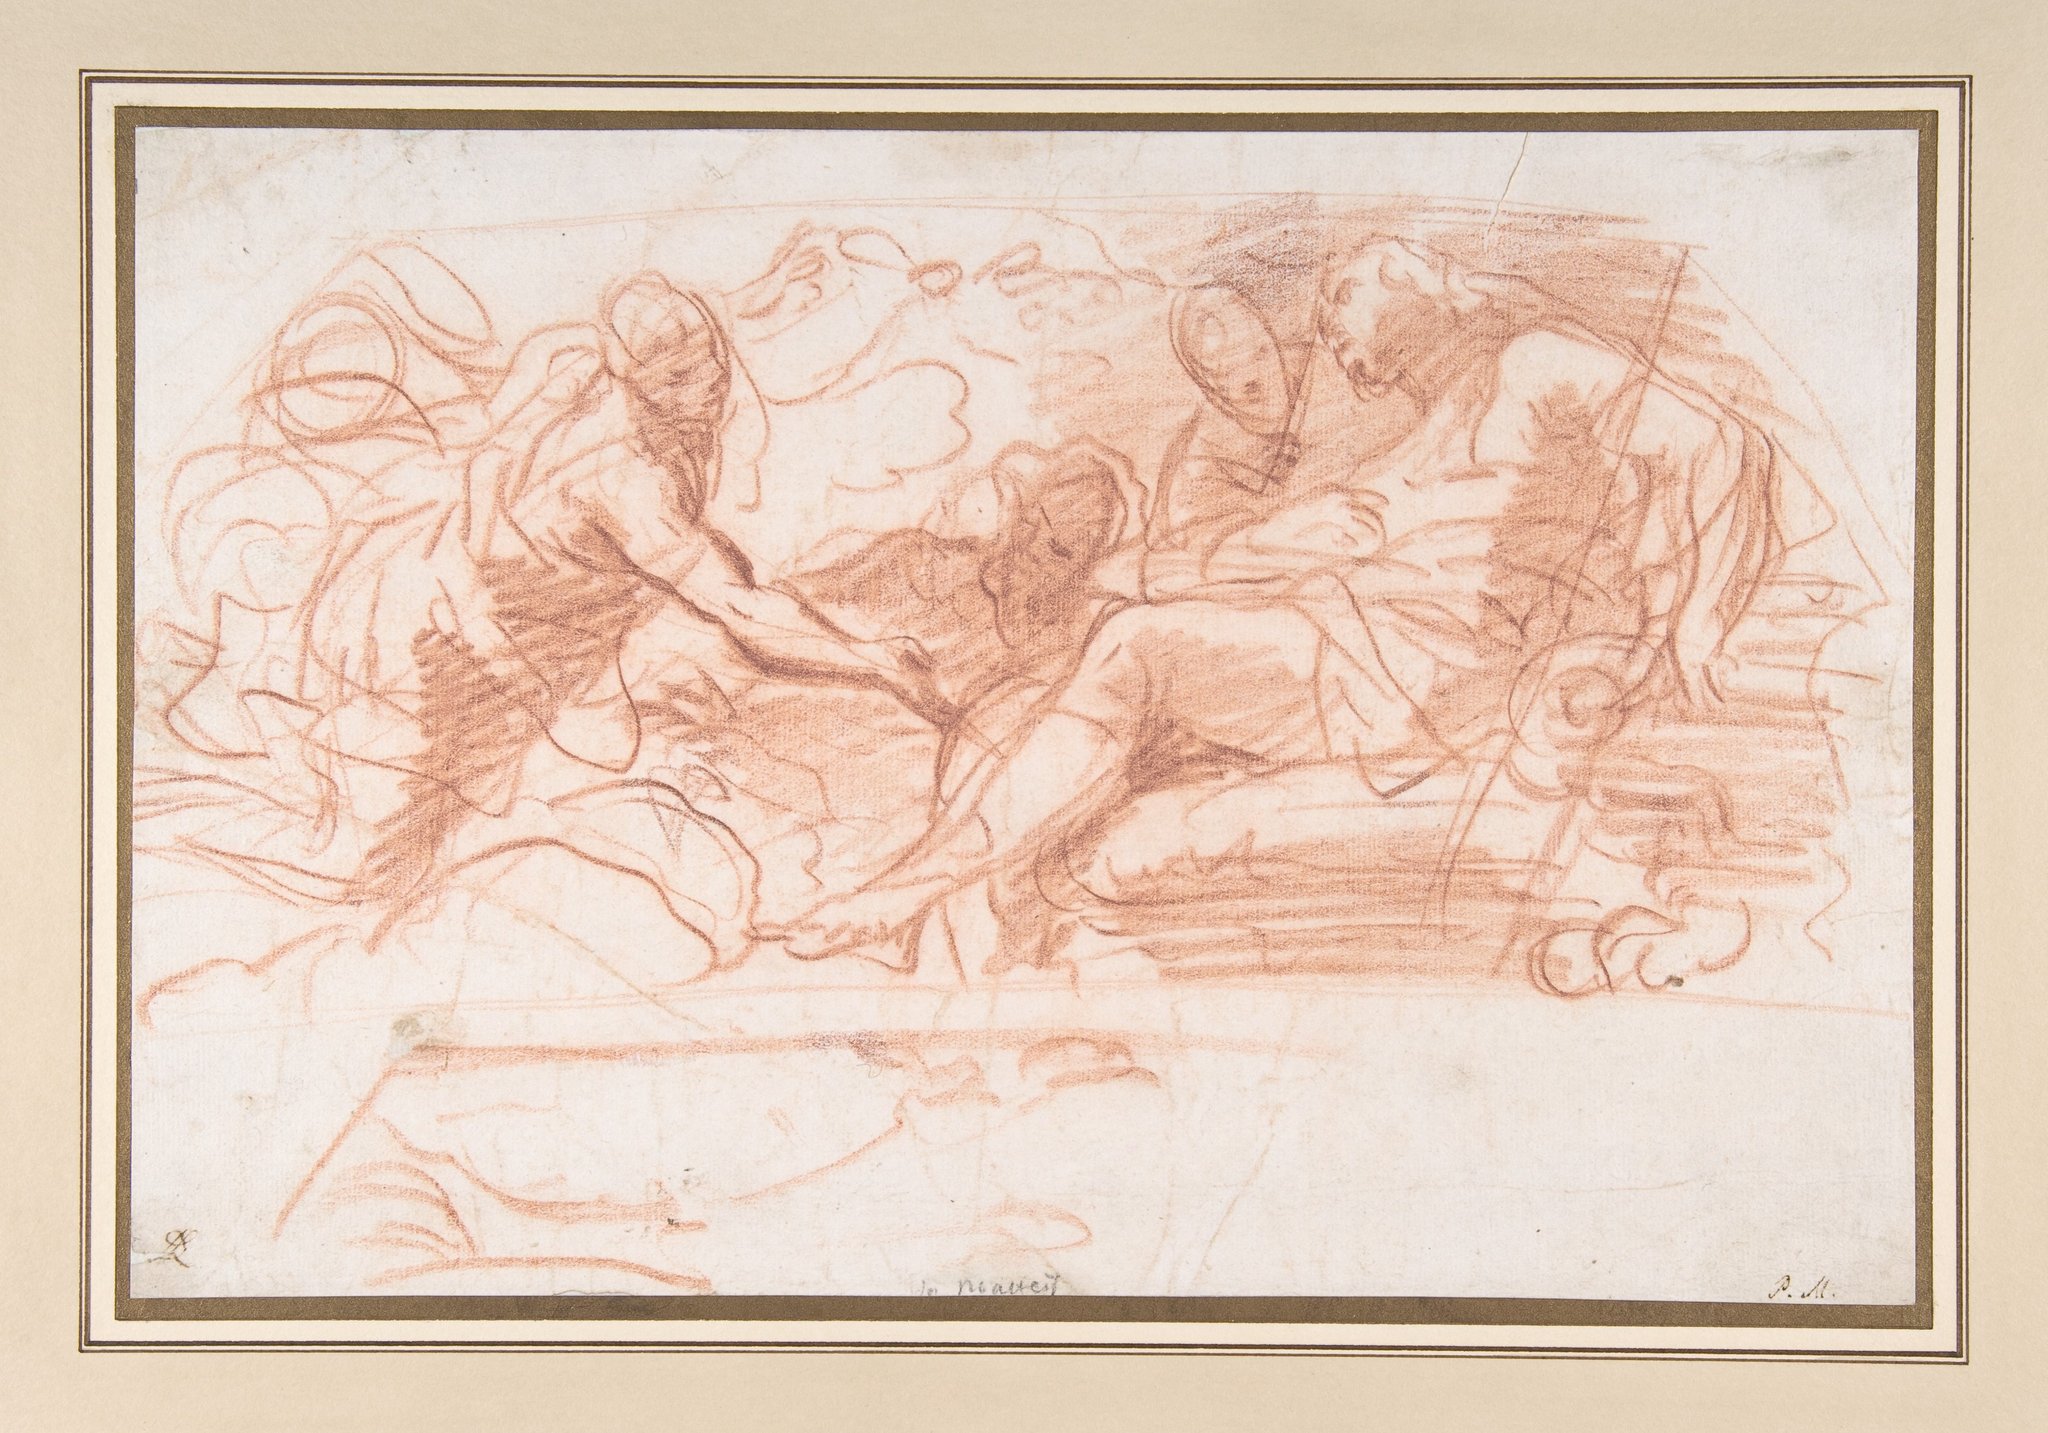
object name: drawing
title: Flying Figure Appearing before an Enthroned Figure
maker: paolo de matteis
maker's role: artist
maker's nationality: italian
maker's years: 1662-1728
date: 1662-1728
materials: chalk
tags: human figures